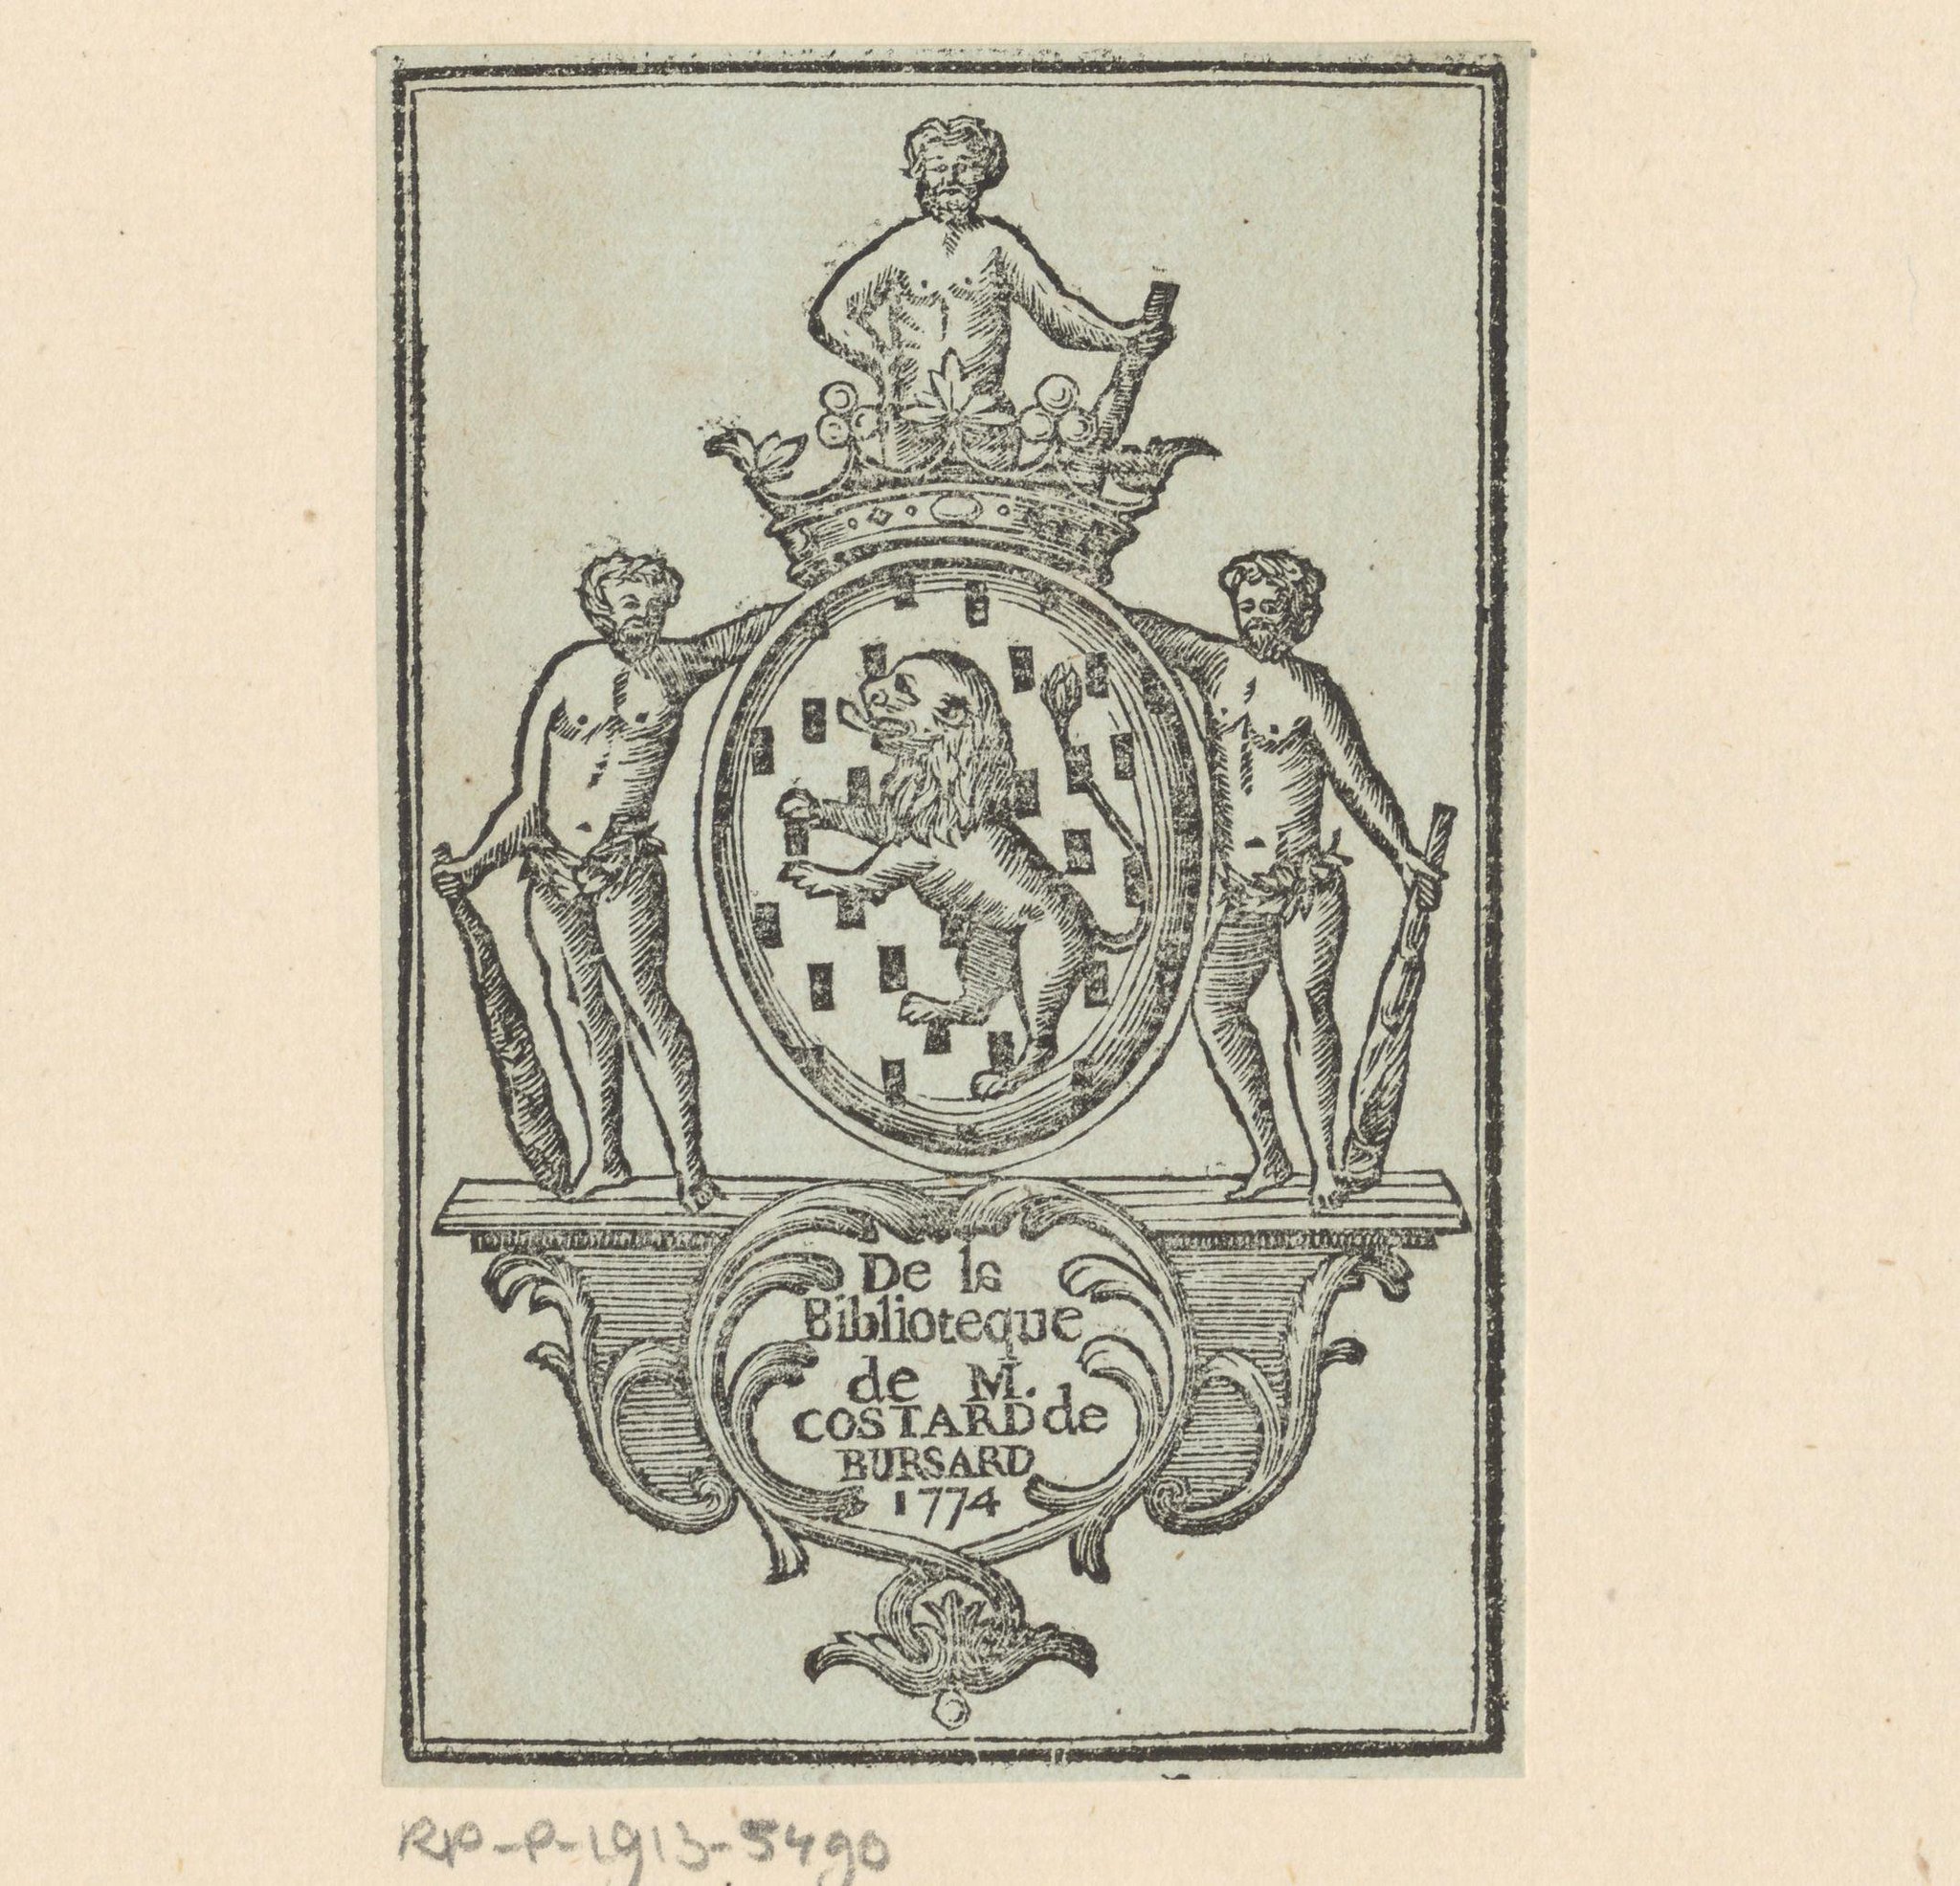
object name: bookplate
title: Ex libris van Jean-Jacques Costard de Bursard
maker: Anonymous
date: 1774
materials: paper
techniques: woodcut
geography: france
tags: standing figure, beasts of prey, predatory animals: lion, weapons for striking a blow: club, armorial bearing, heraldry, man (showing himself) undressed, quasi-nude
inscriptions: collector's mark: Lugt 2760, collector's mark: Lugt 2233